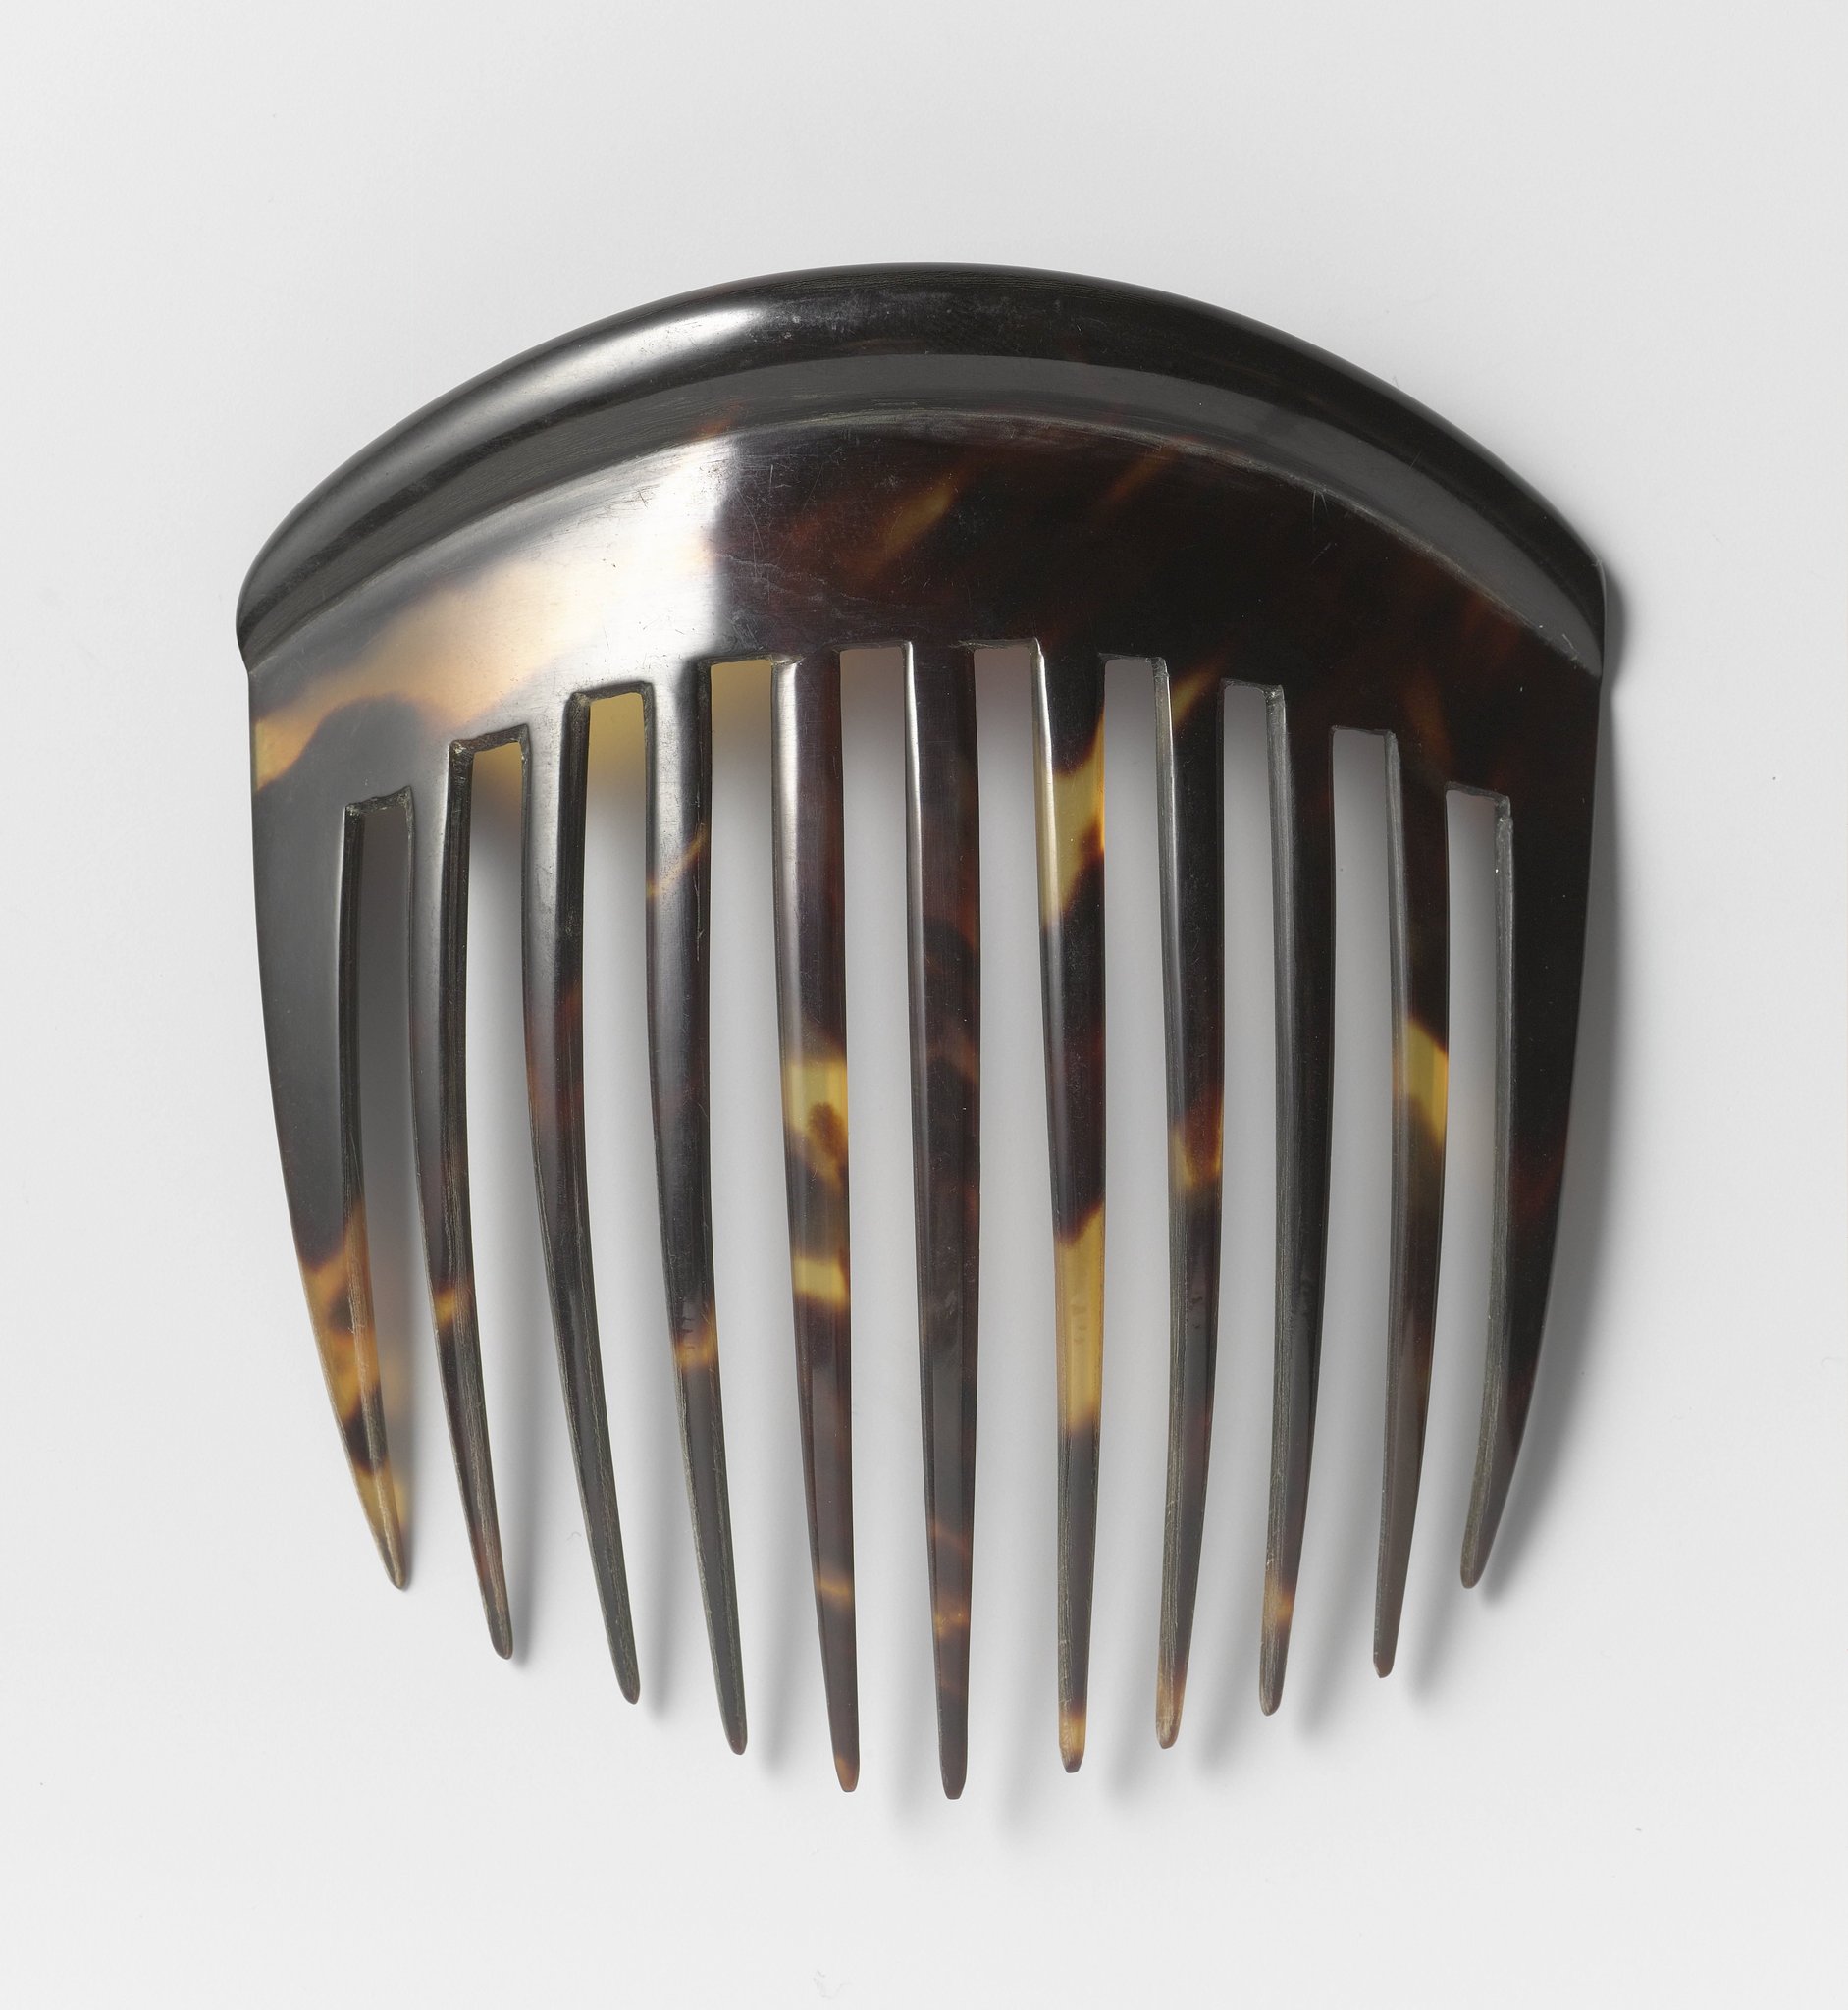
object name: comb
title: Haarkam van imitatie schildpad met onversierde ronde rug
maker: Anonymous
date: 1800-1900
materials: celluloid, horn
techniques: filing, polish, pressing, sawing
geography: netherlands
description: Haarkam van imitatie schildpad met onversierde ronde rug. Elf tanden.